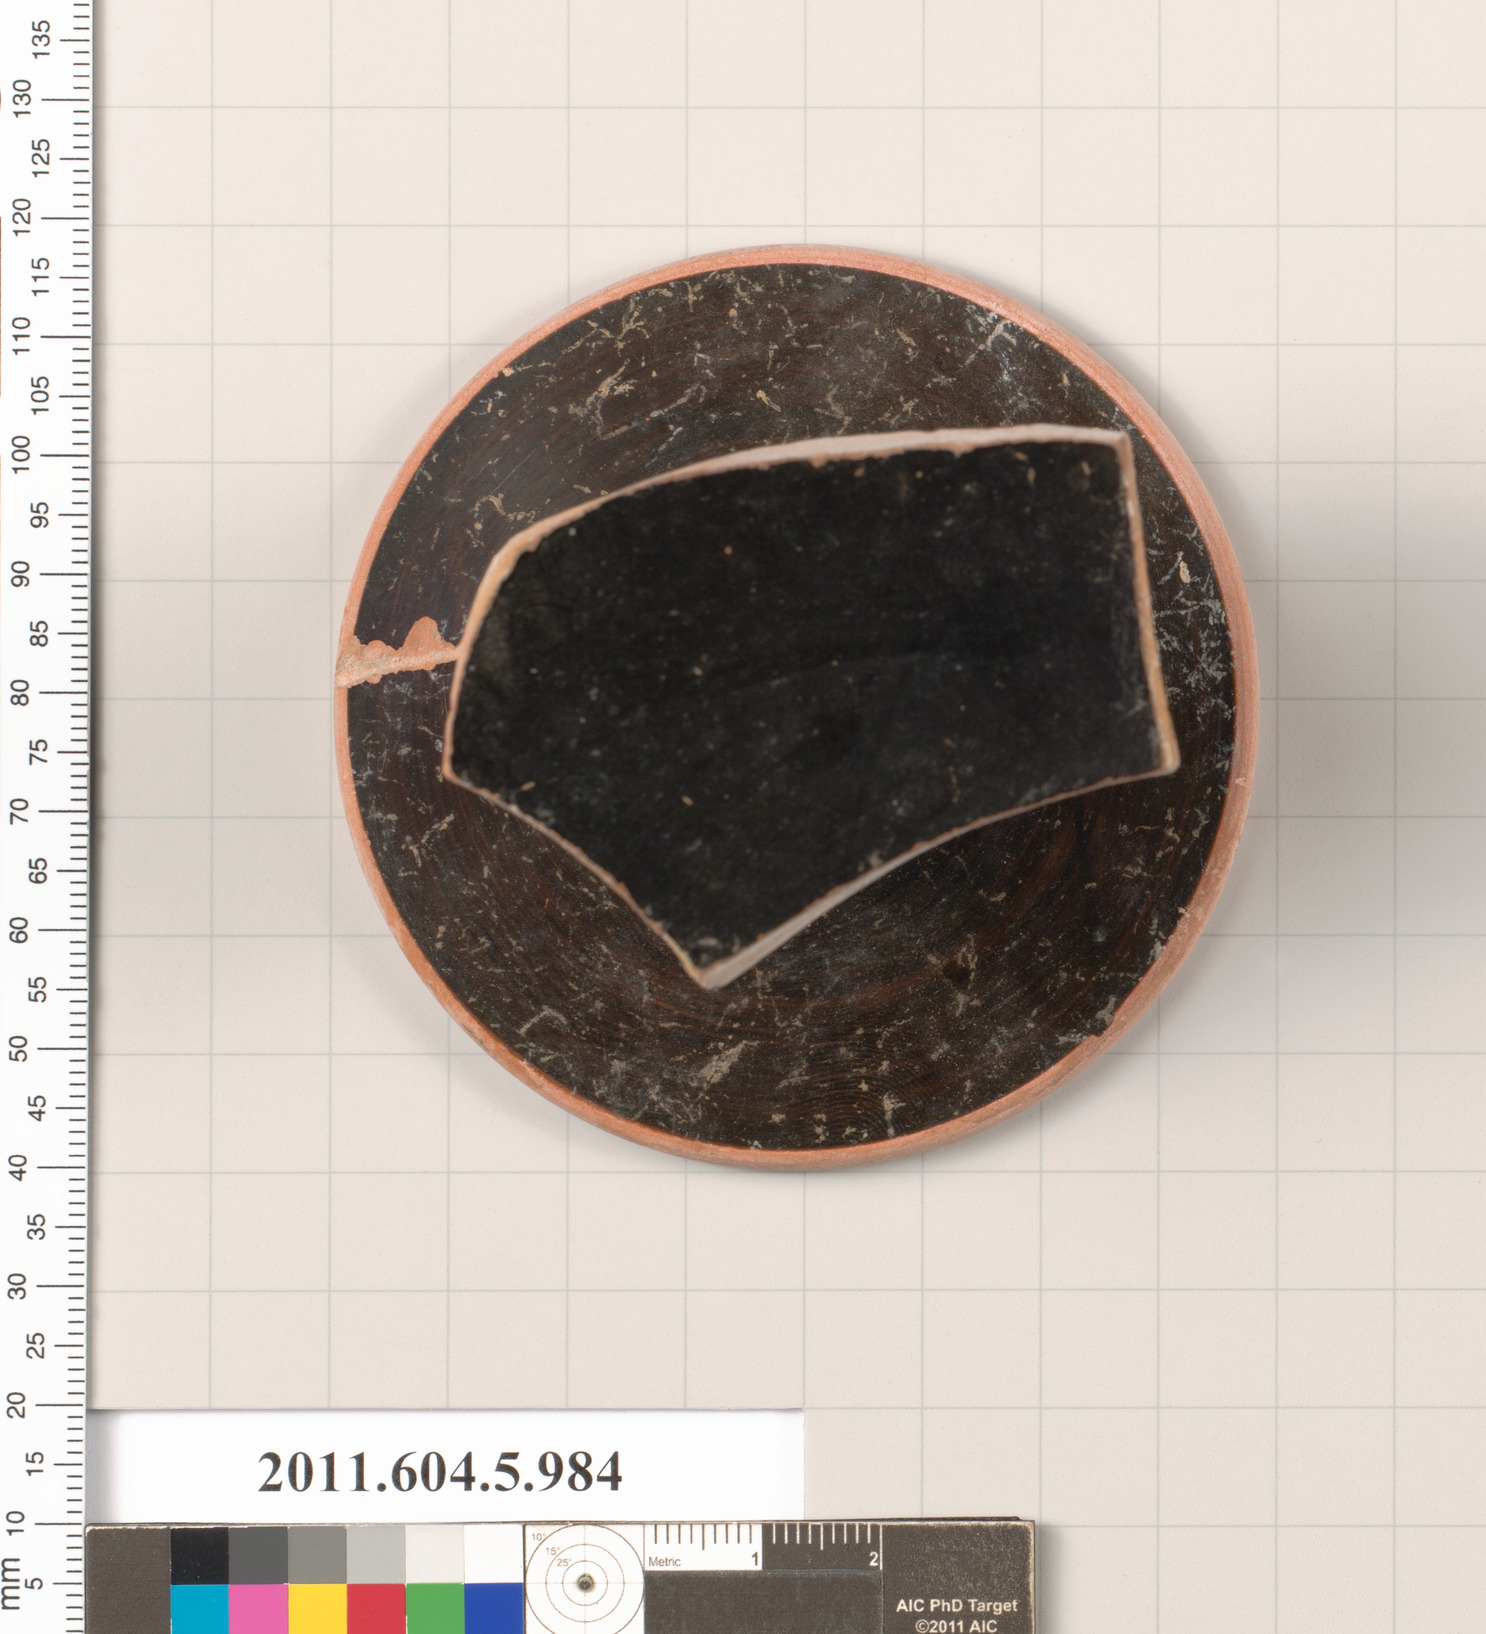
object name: kylix fragment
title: Terracotta fragment of a kylix (drinking cup)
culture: greek, attic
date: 600-401 BCE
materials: terracotta